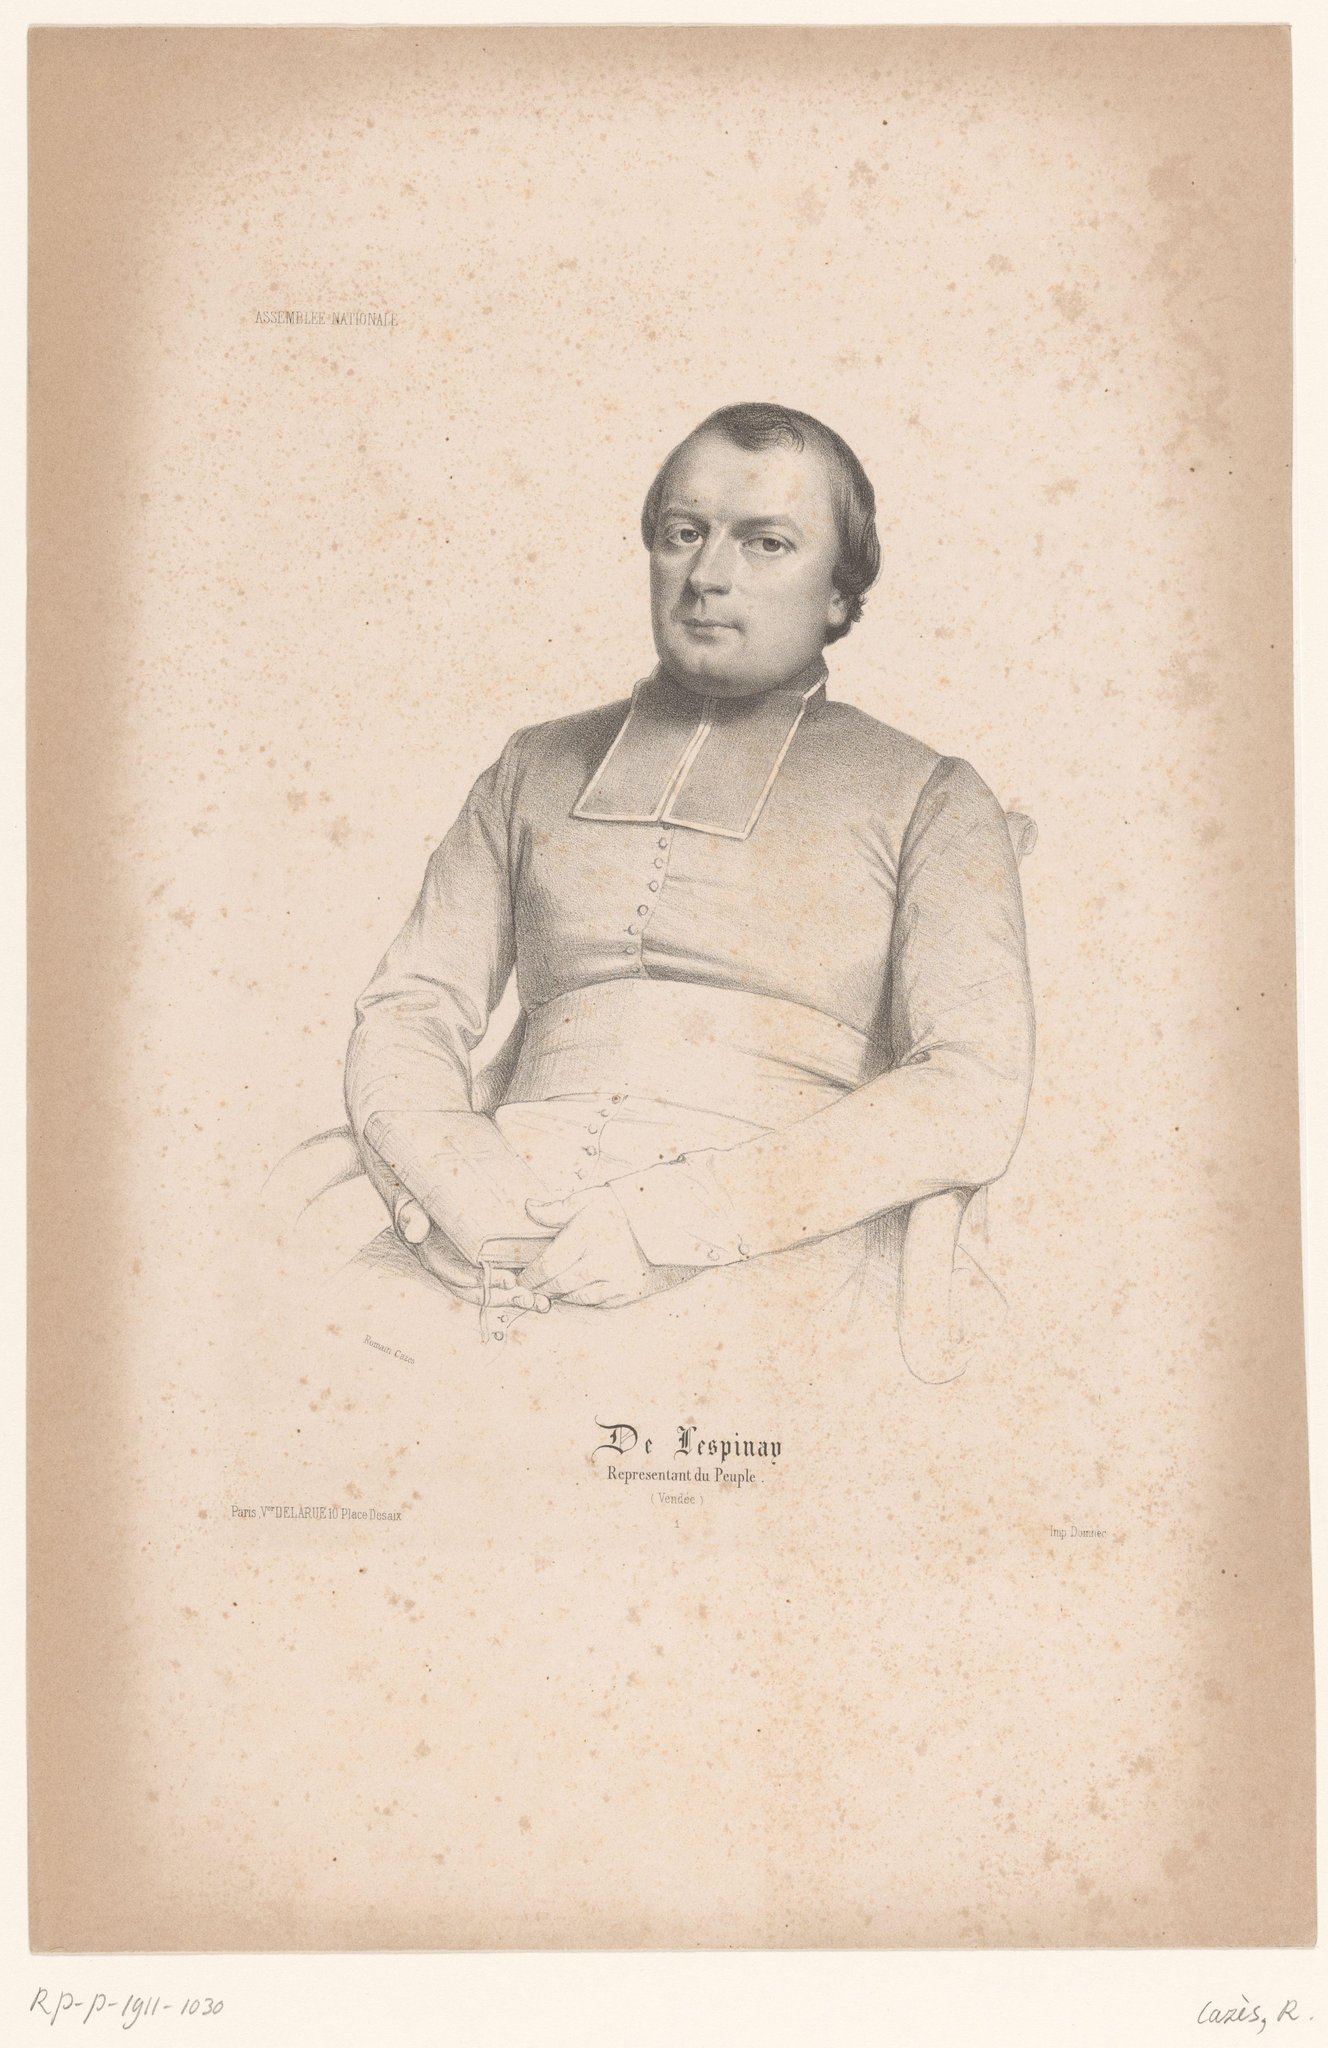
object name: print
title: Portret van de geestelijke Henri Victor de L'Espinay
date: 1848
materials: paper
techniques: lithograph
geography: paris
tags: politician, clergyman, historical persons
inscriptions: collector's mark: Lugt 2228a